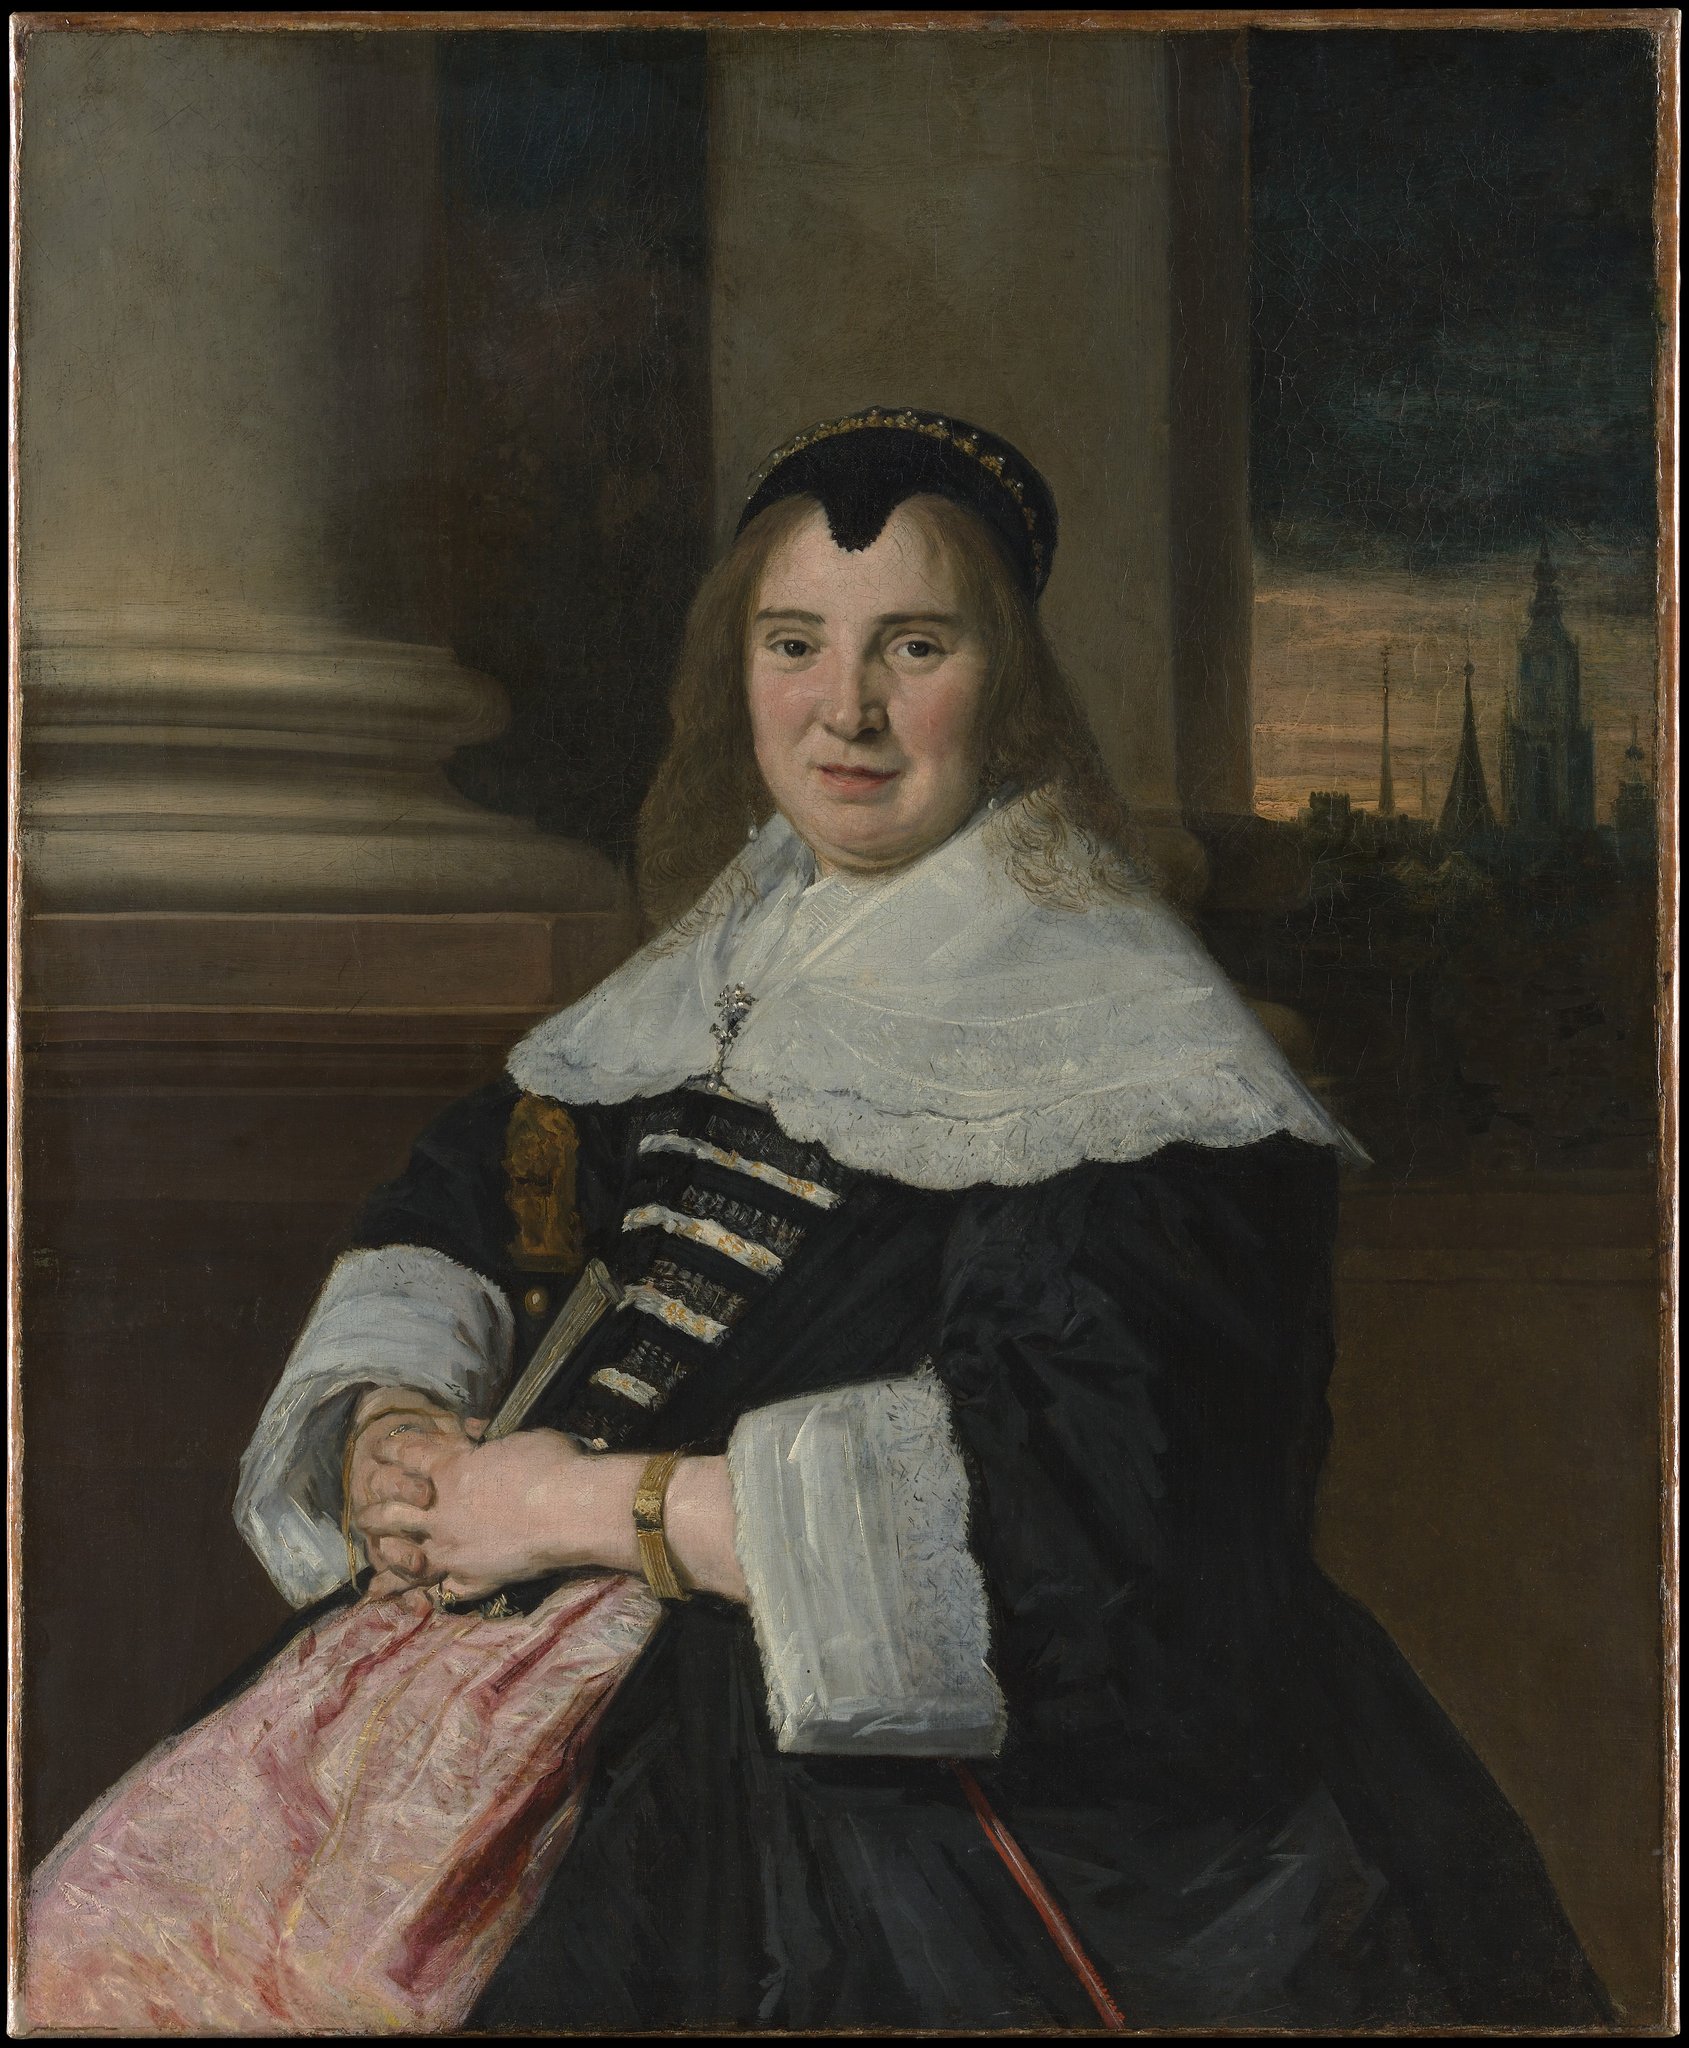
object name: painting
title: Portrait of a Woman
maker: frans hals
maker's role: artist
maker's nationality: dutch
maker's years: 1582-1666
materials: canvas, oil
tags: portraits,women